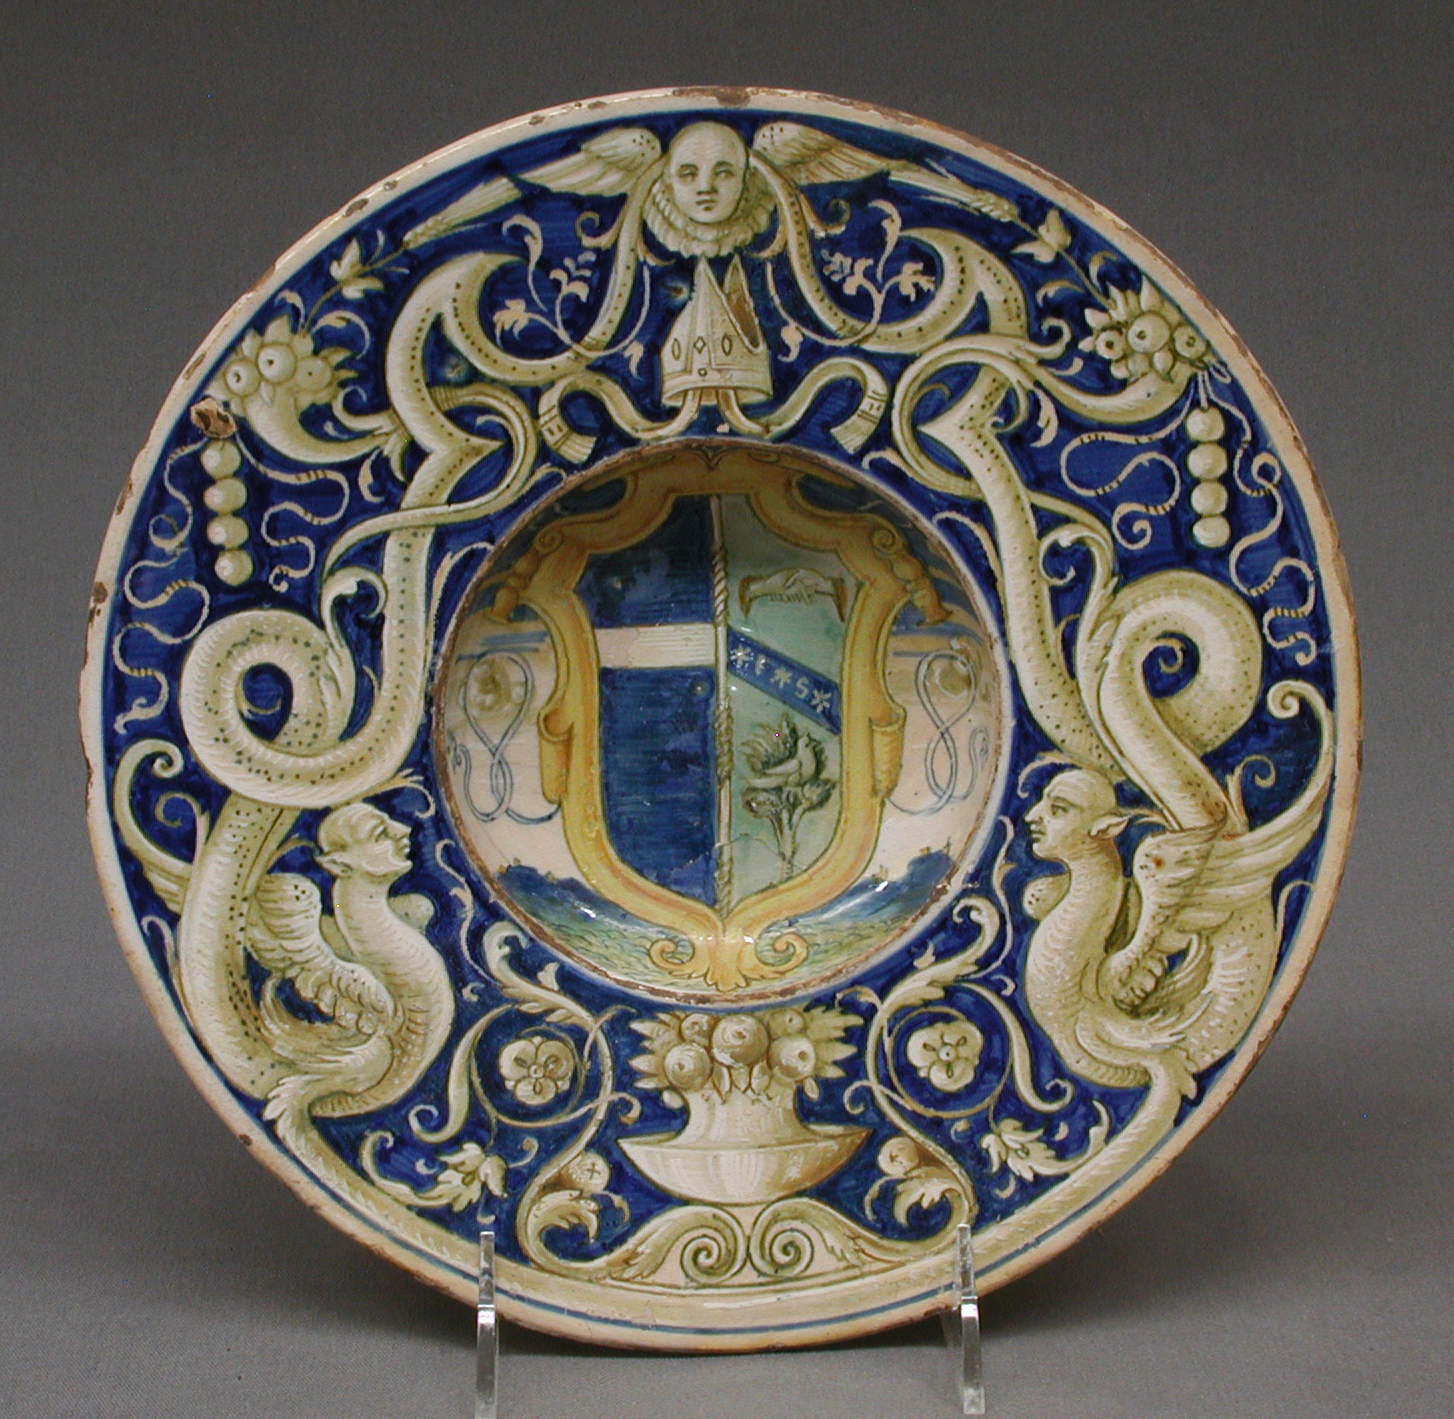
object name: dish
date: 1530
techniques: maiolica, glazing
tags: coat of arms